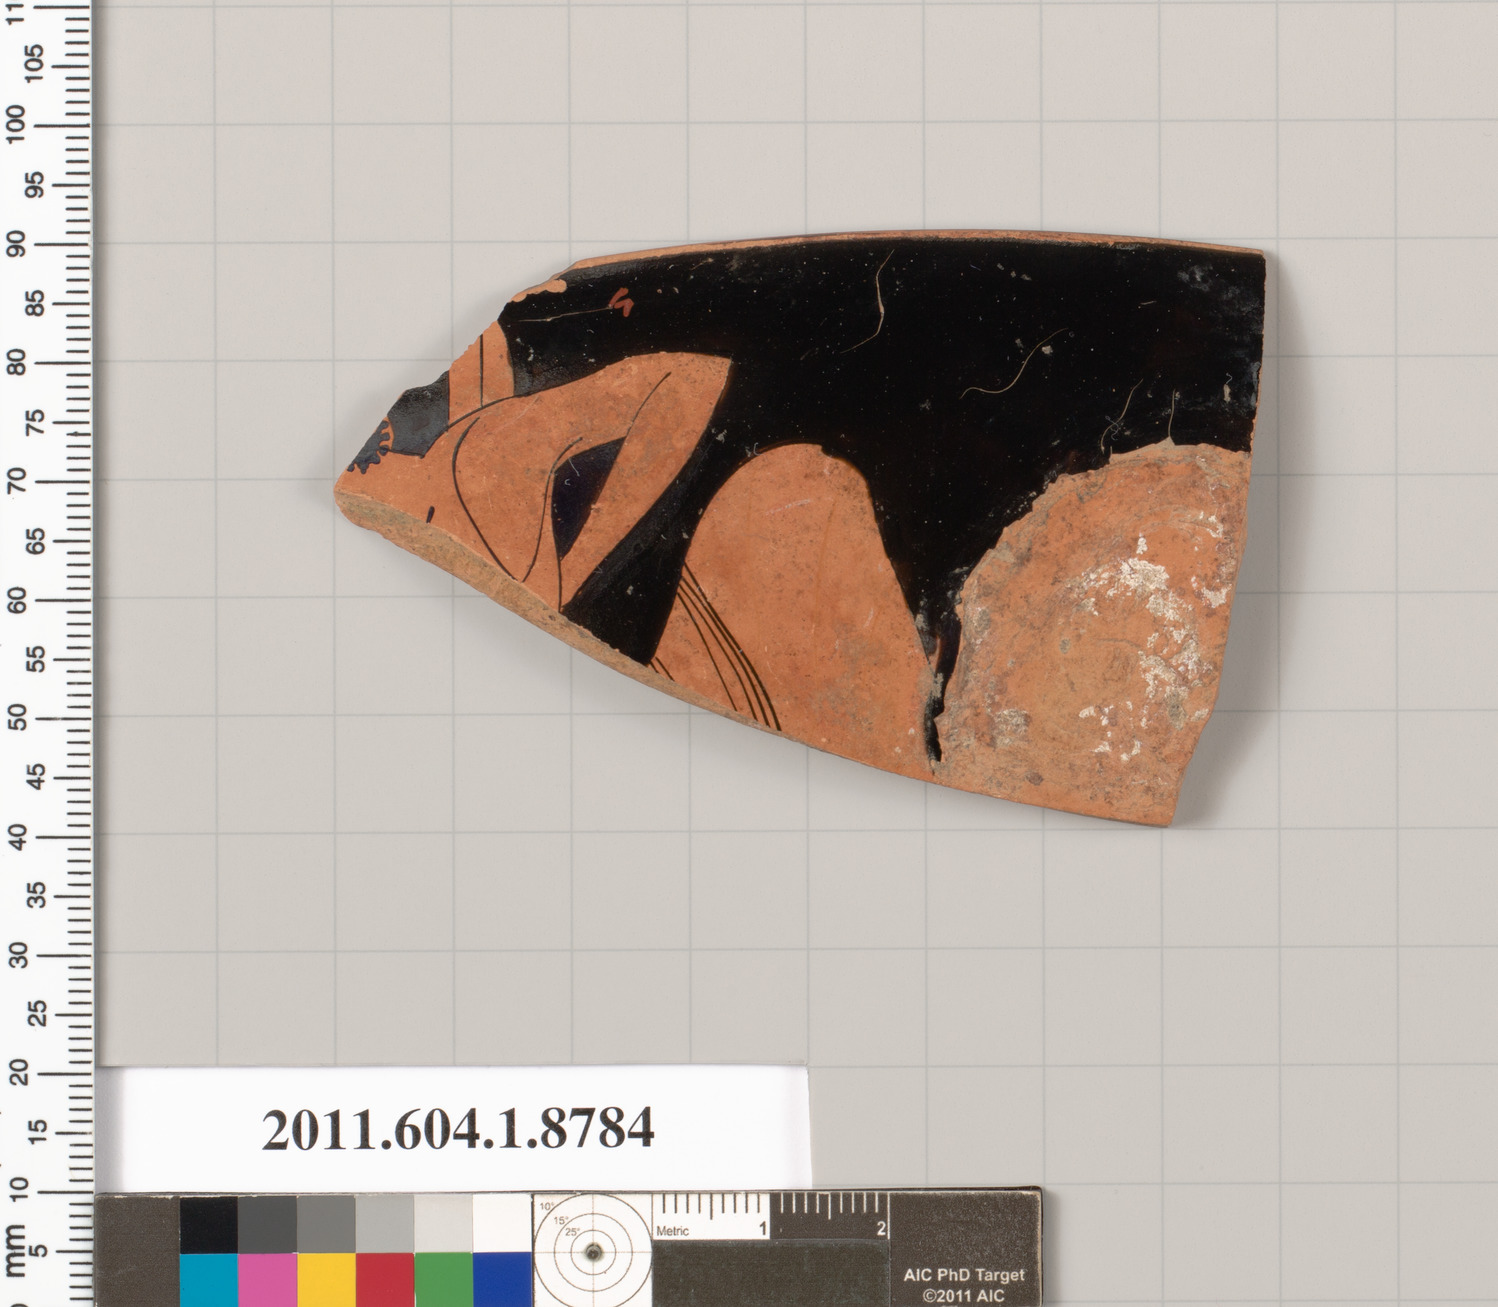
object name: kylix fragment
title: Terracotta rim fragment of a kylix (drinking cup)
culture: greek, attic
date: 490-480 BCE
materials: terracotta